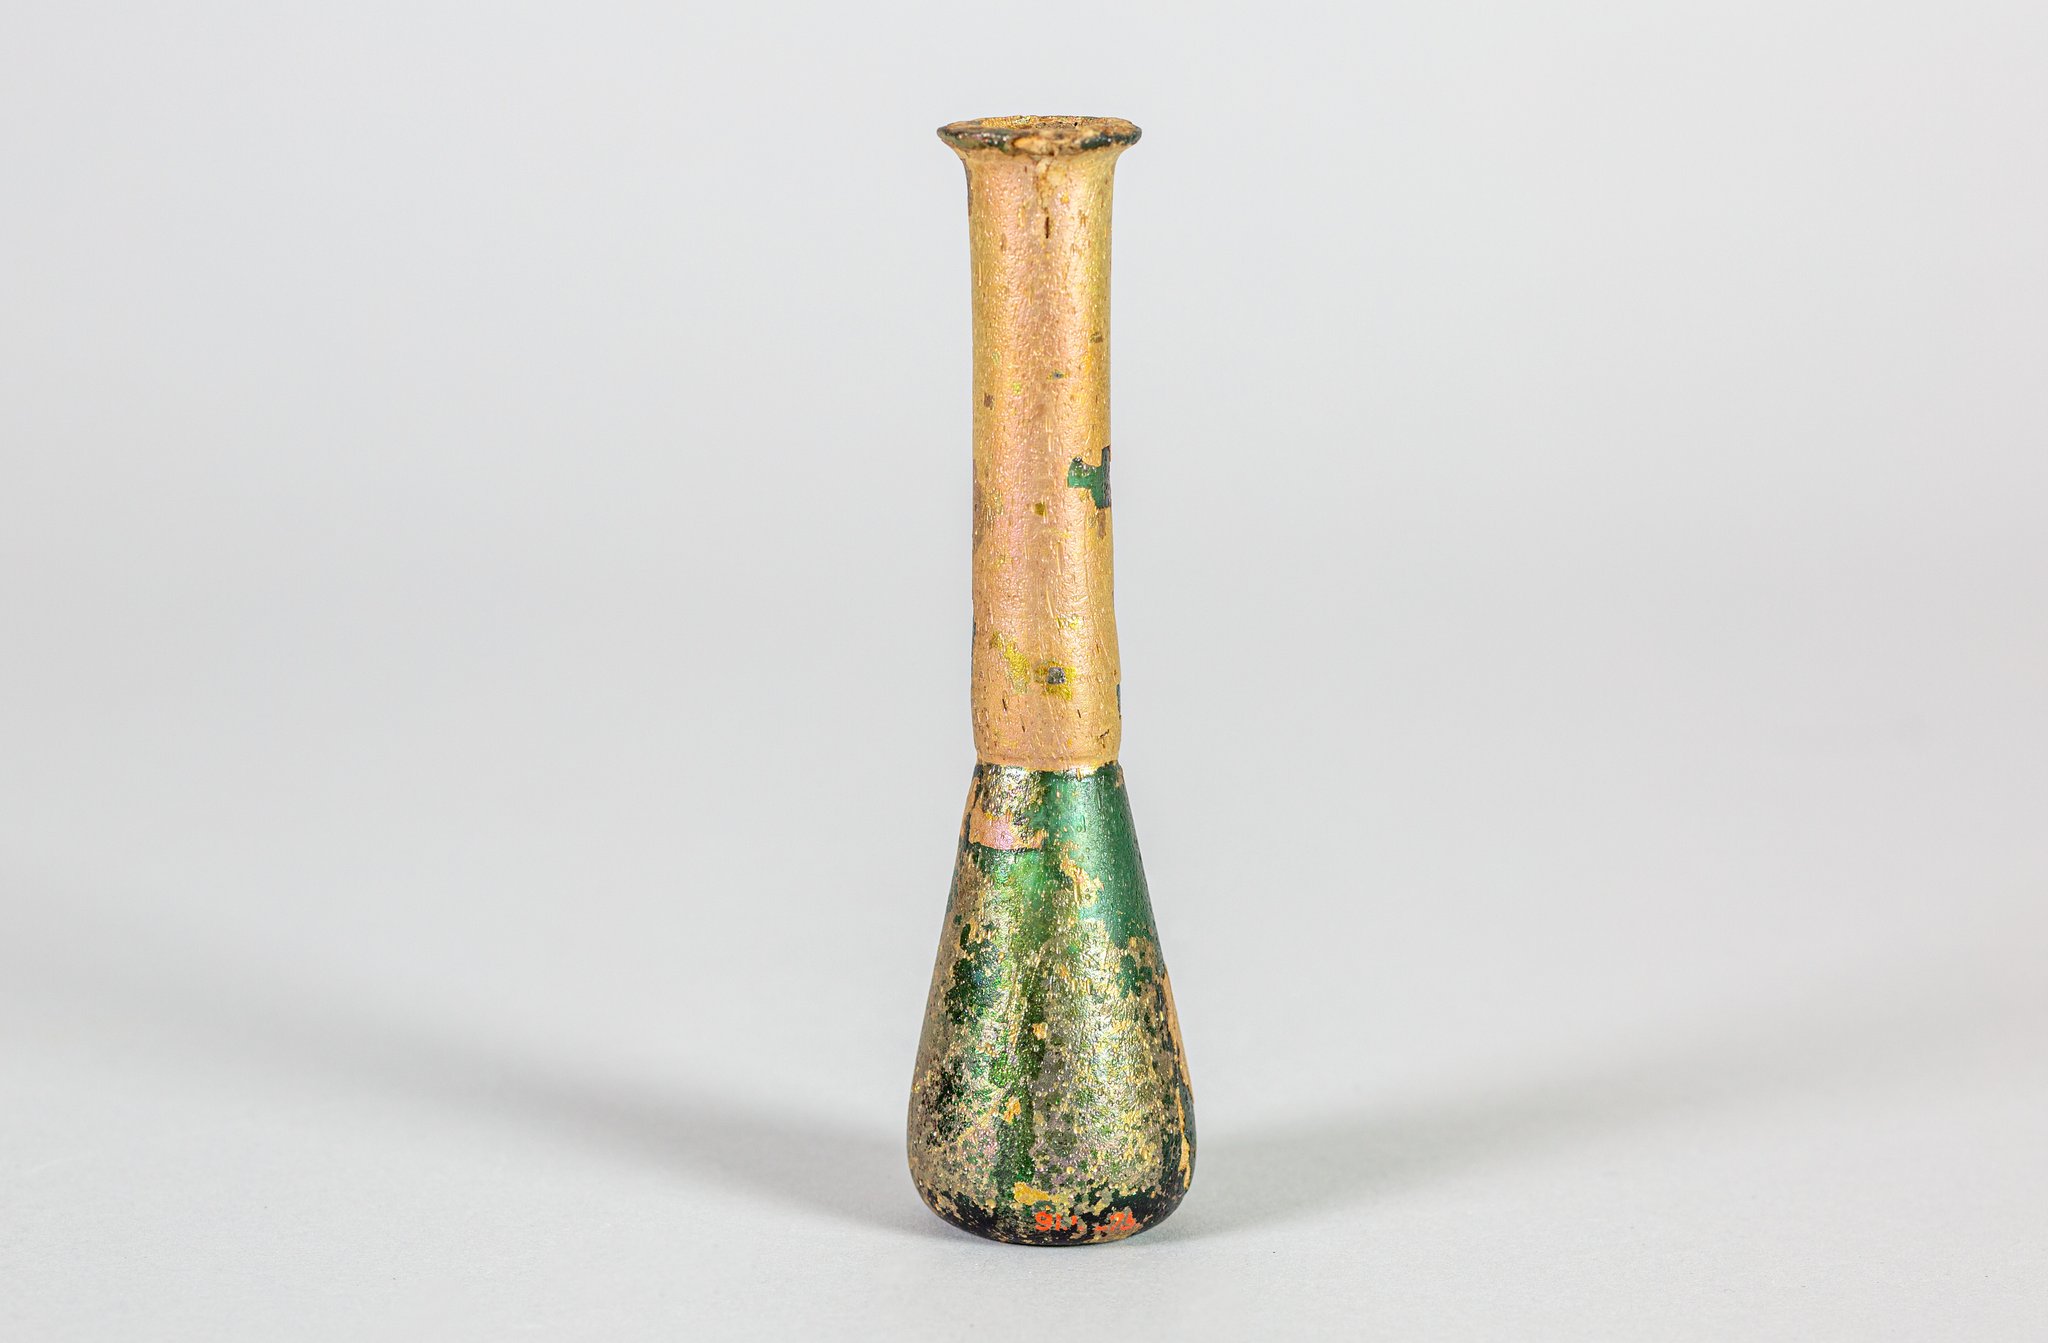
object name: bottle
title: Glass perfume bottle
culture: roman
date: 67-300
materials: glass